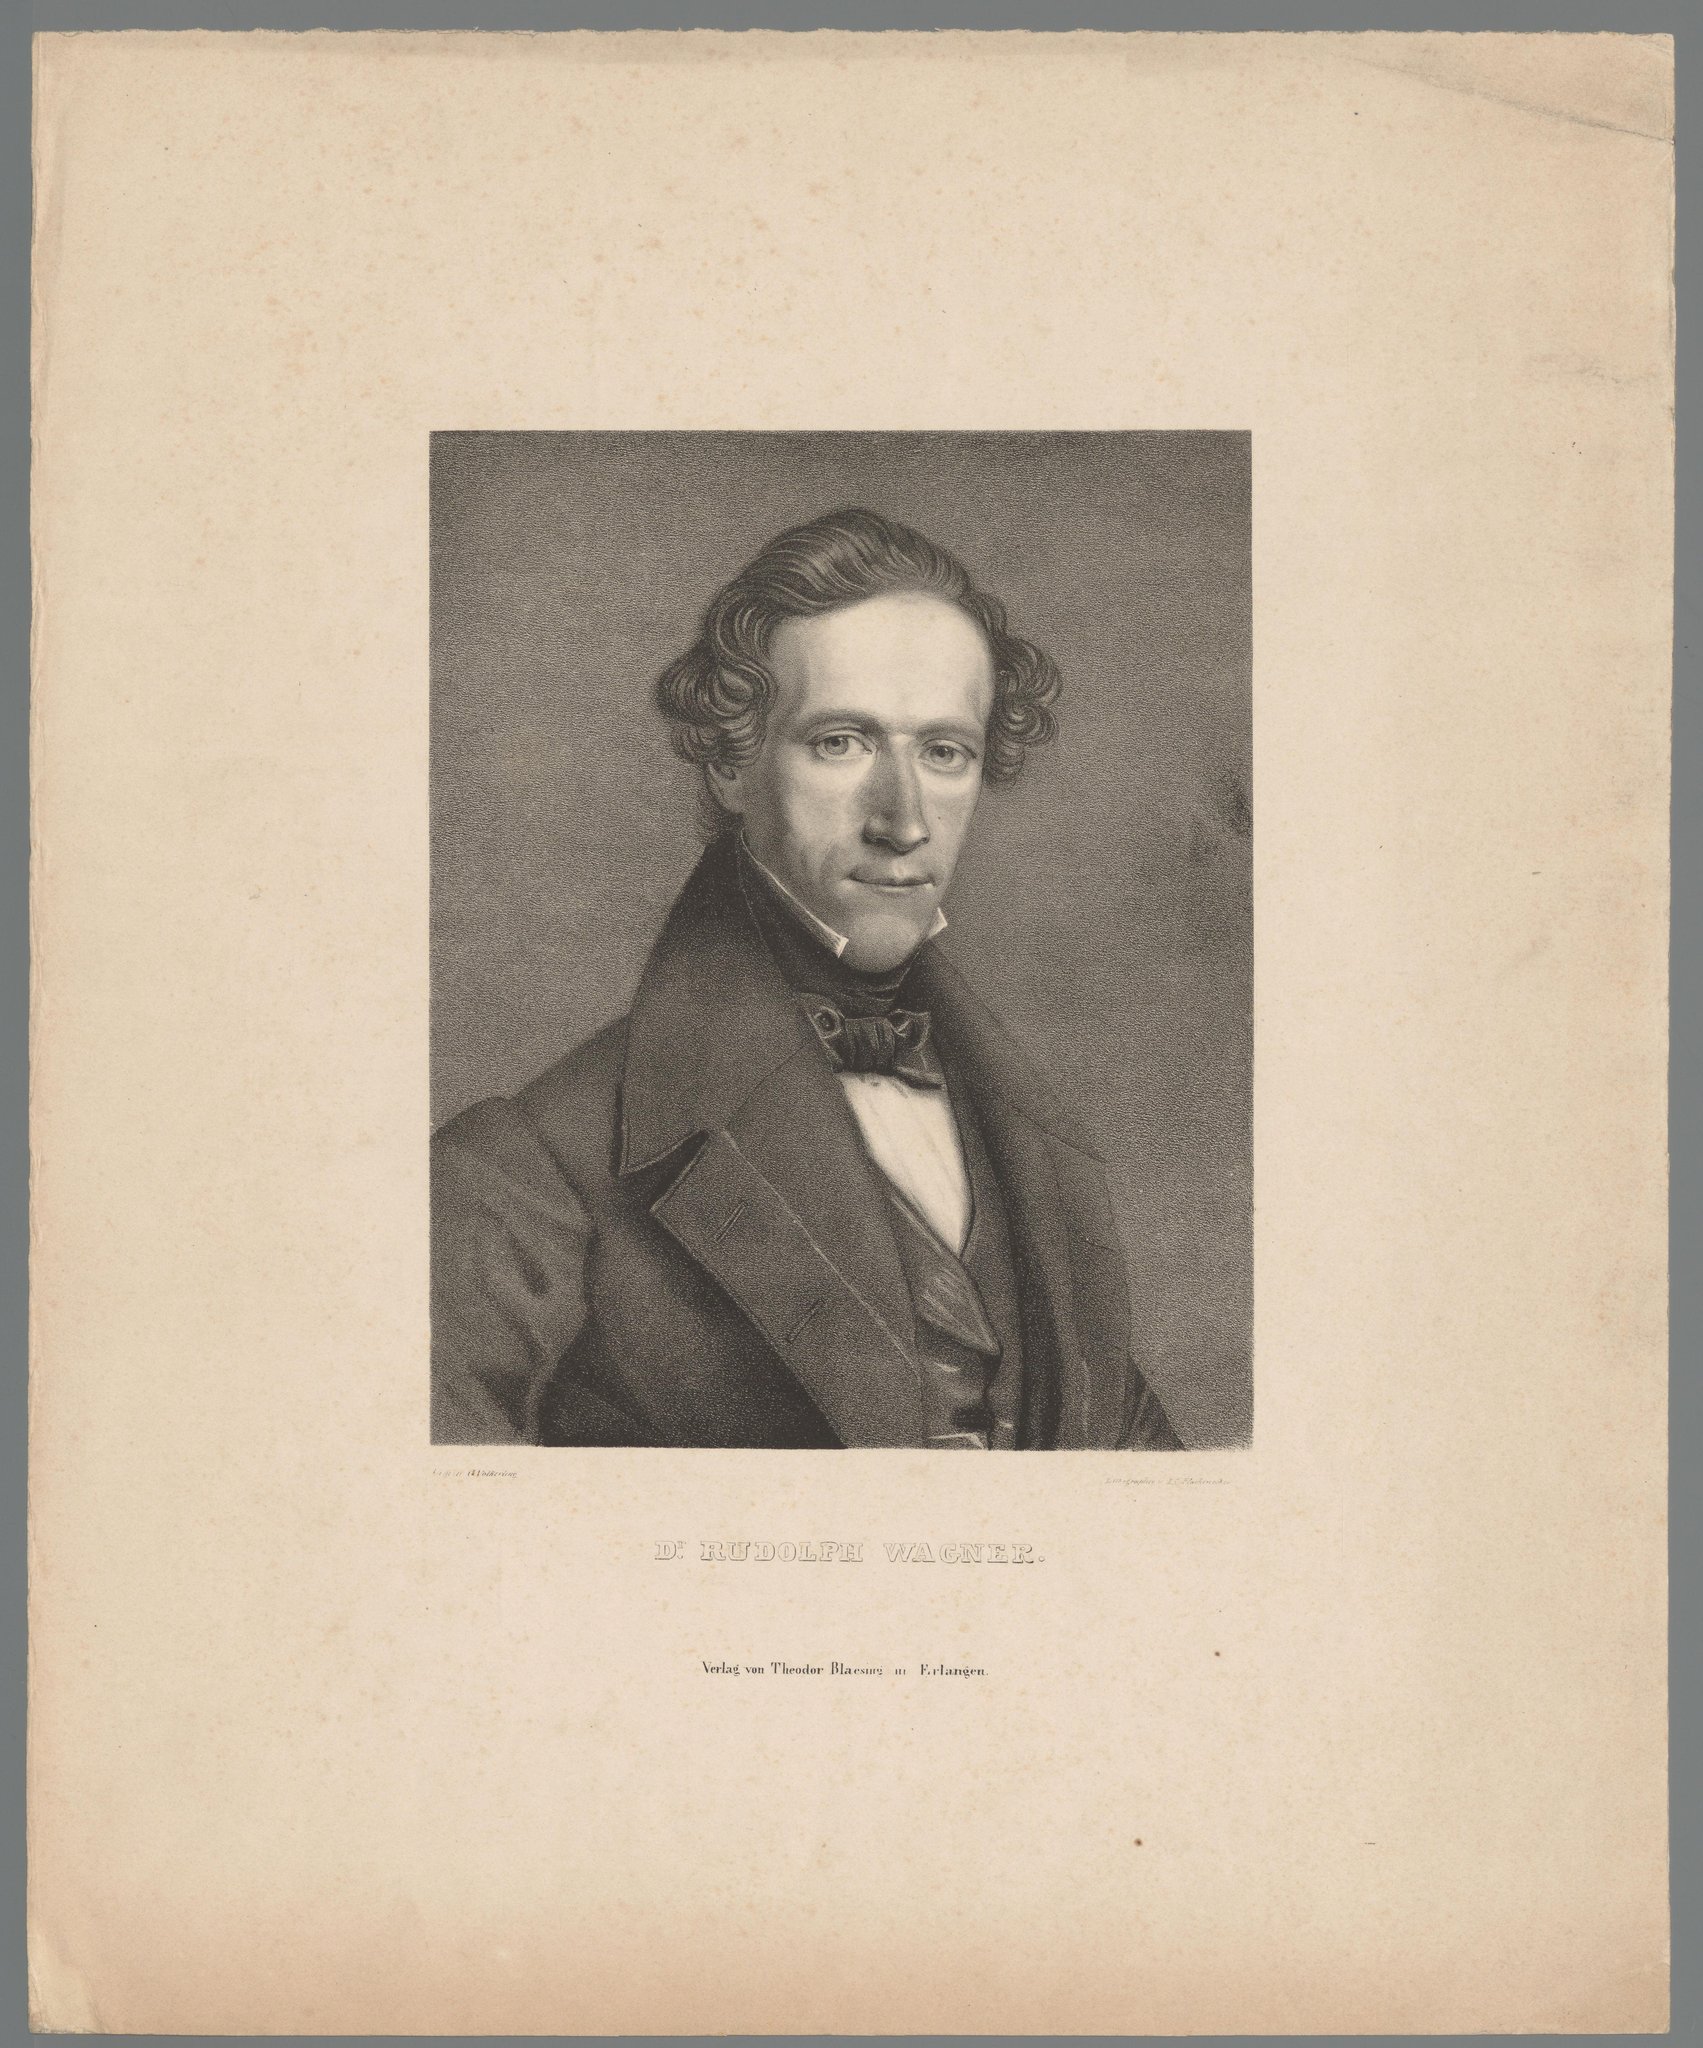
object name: print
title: Portret van Rudolf Wagner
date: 1830-1863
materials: paper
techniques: lithograph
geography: erlangen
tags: historical persons, physiology and anatomy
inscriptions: collector's mark: Lugt 2228